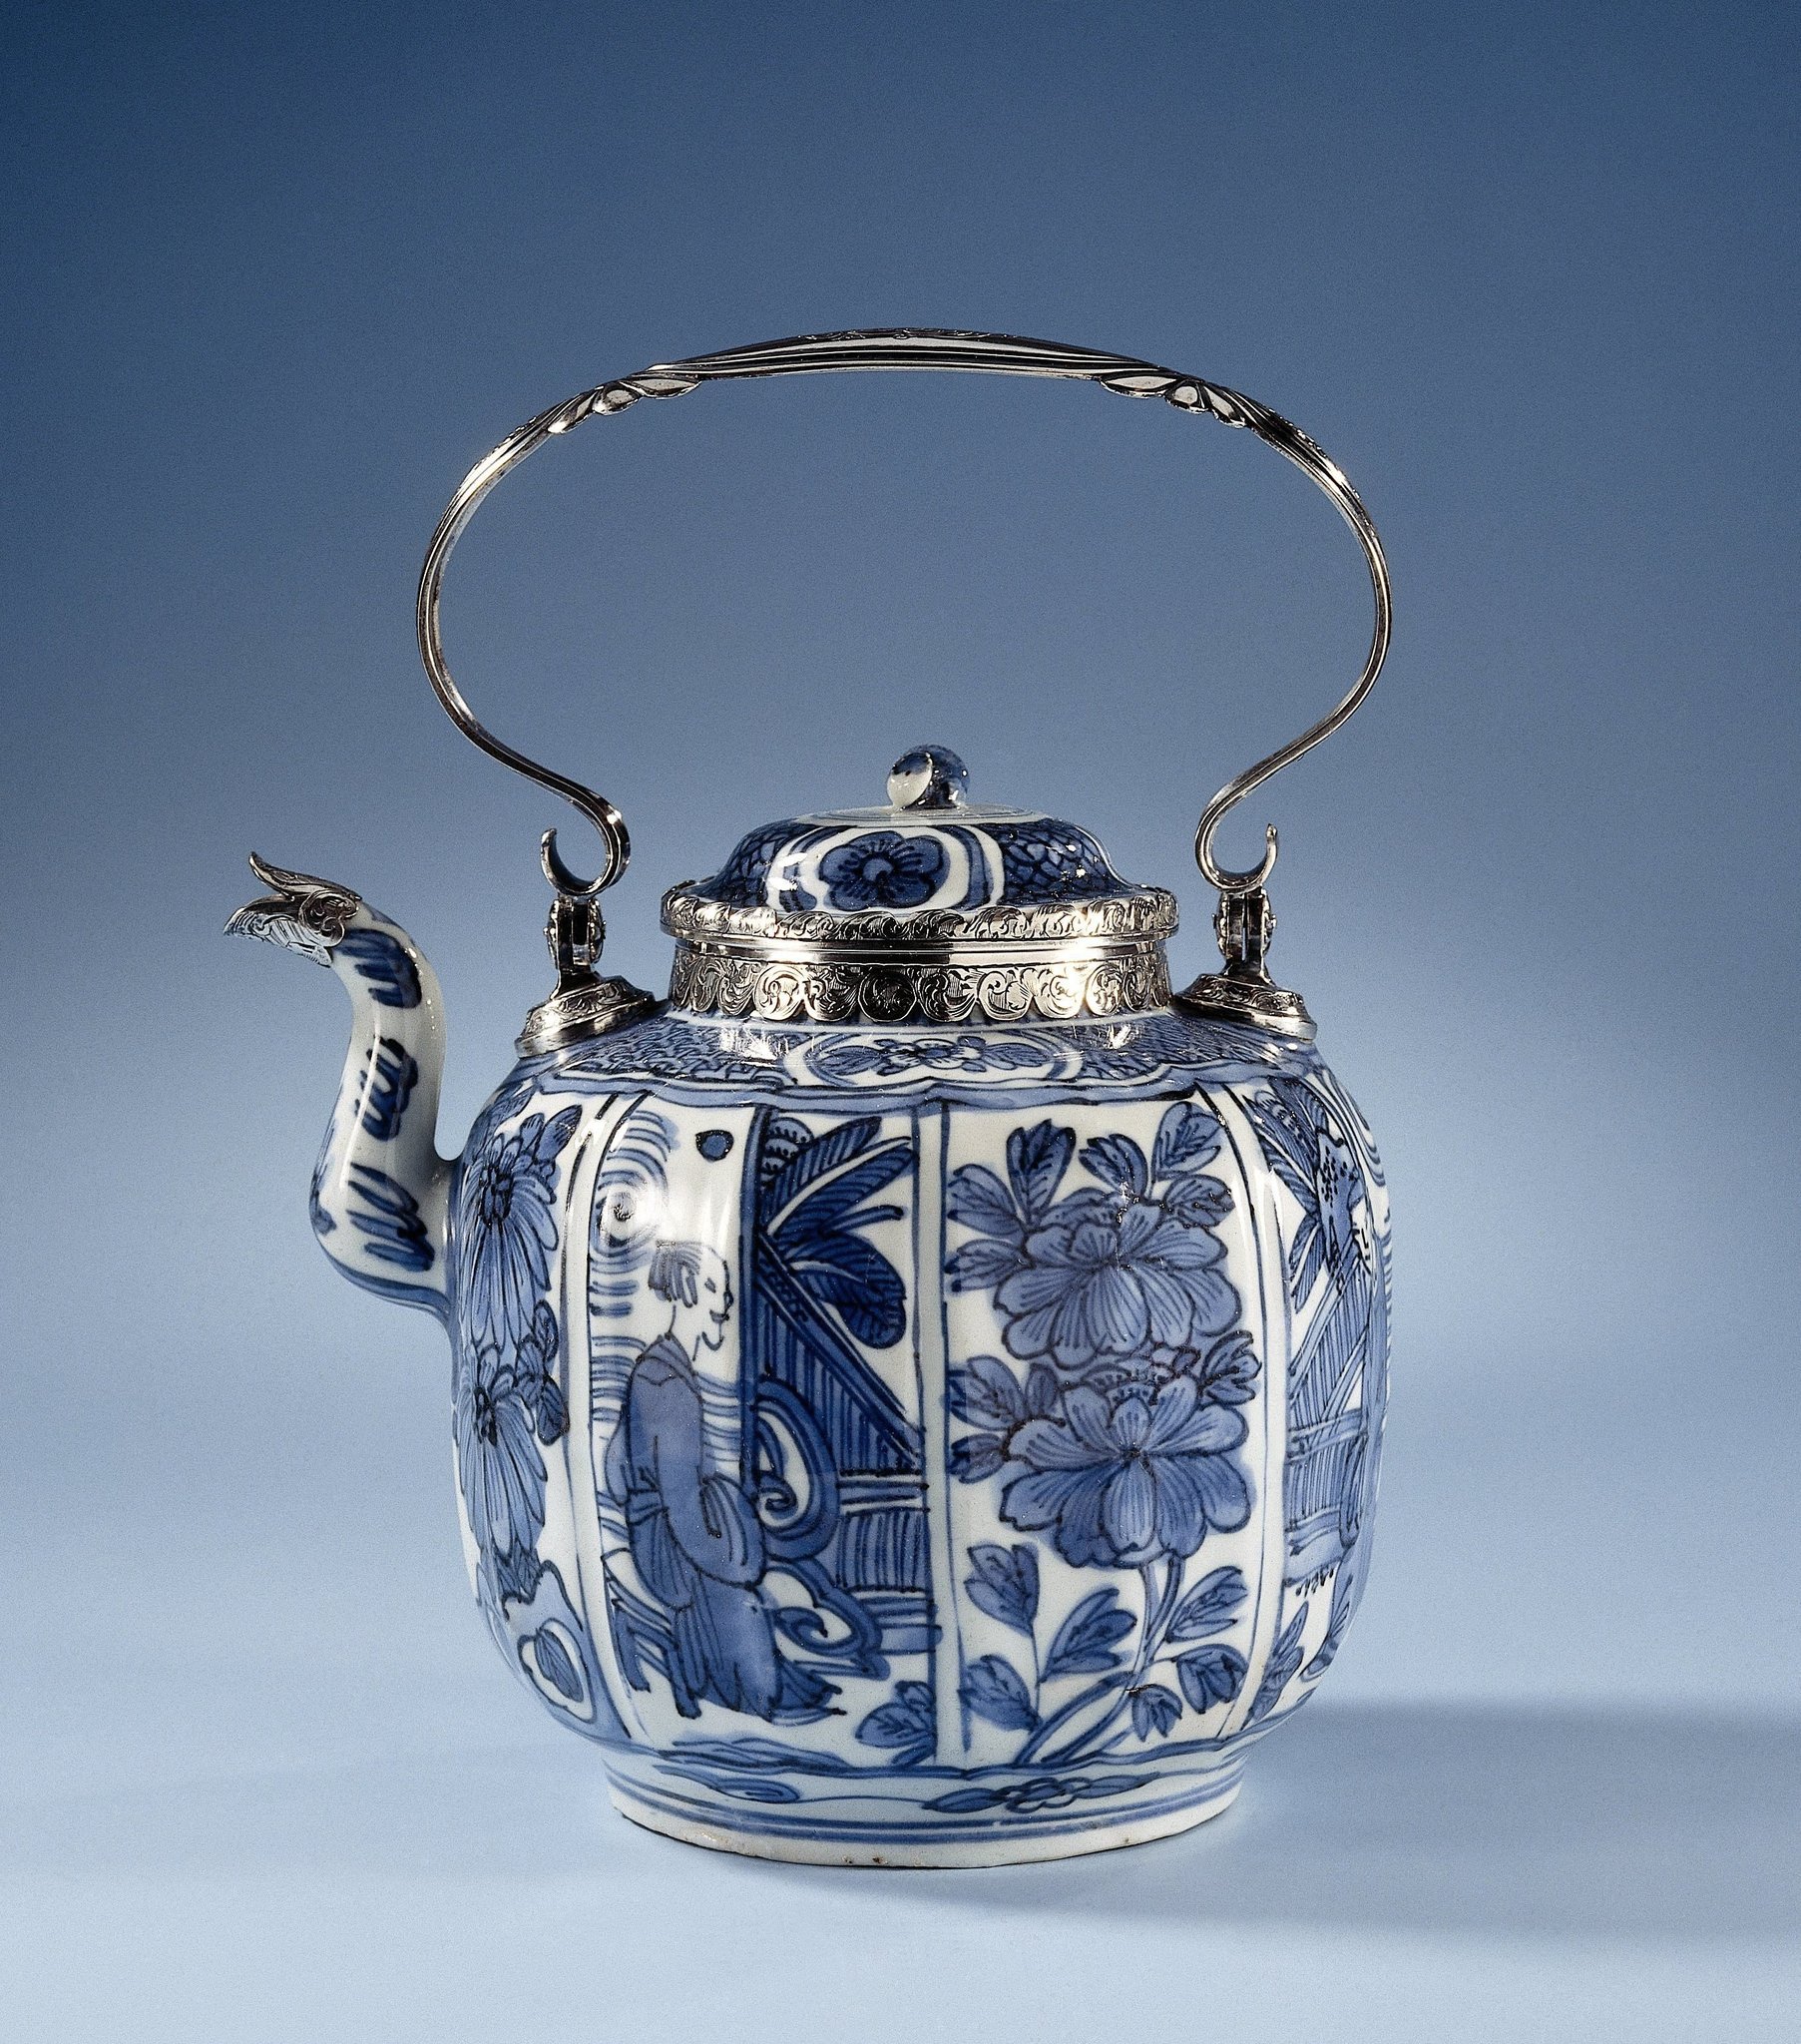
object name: teapot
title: Teapot with panel decoration with flowering plants, figures and silver mounts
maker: Anonymous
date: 1610-1630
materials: cobalt, glaze, paint, porcelain, silver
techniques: firing, turning, vitrification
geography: amsterdam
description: Ketel met een s-vormige tuit en een klokvormige deksel; het oorspronkelijke staande handvat is vervangen door een zilveren montuur, vervaardigd door Arnoldi & Wielick, Amsterdam 1850. Gedecoreerd in onderglazuur blauw met in reliëf aangegeven velden. De velden zijn afwisselend gevuld met een dame op een terras en bloeiende planten.